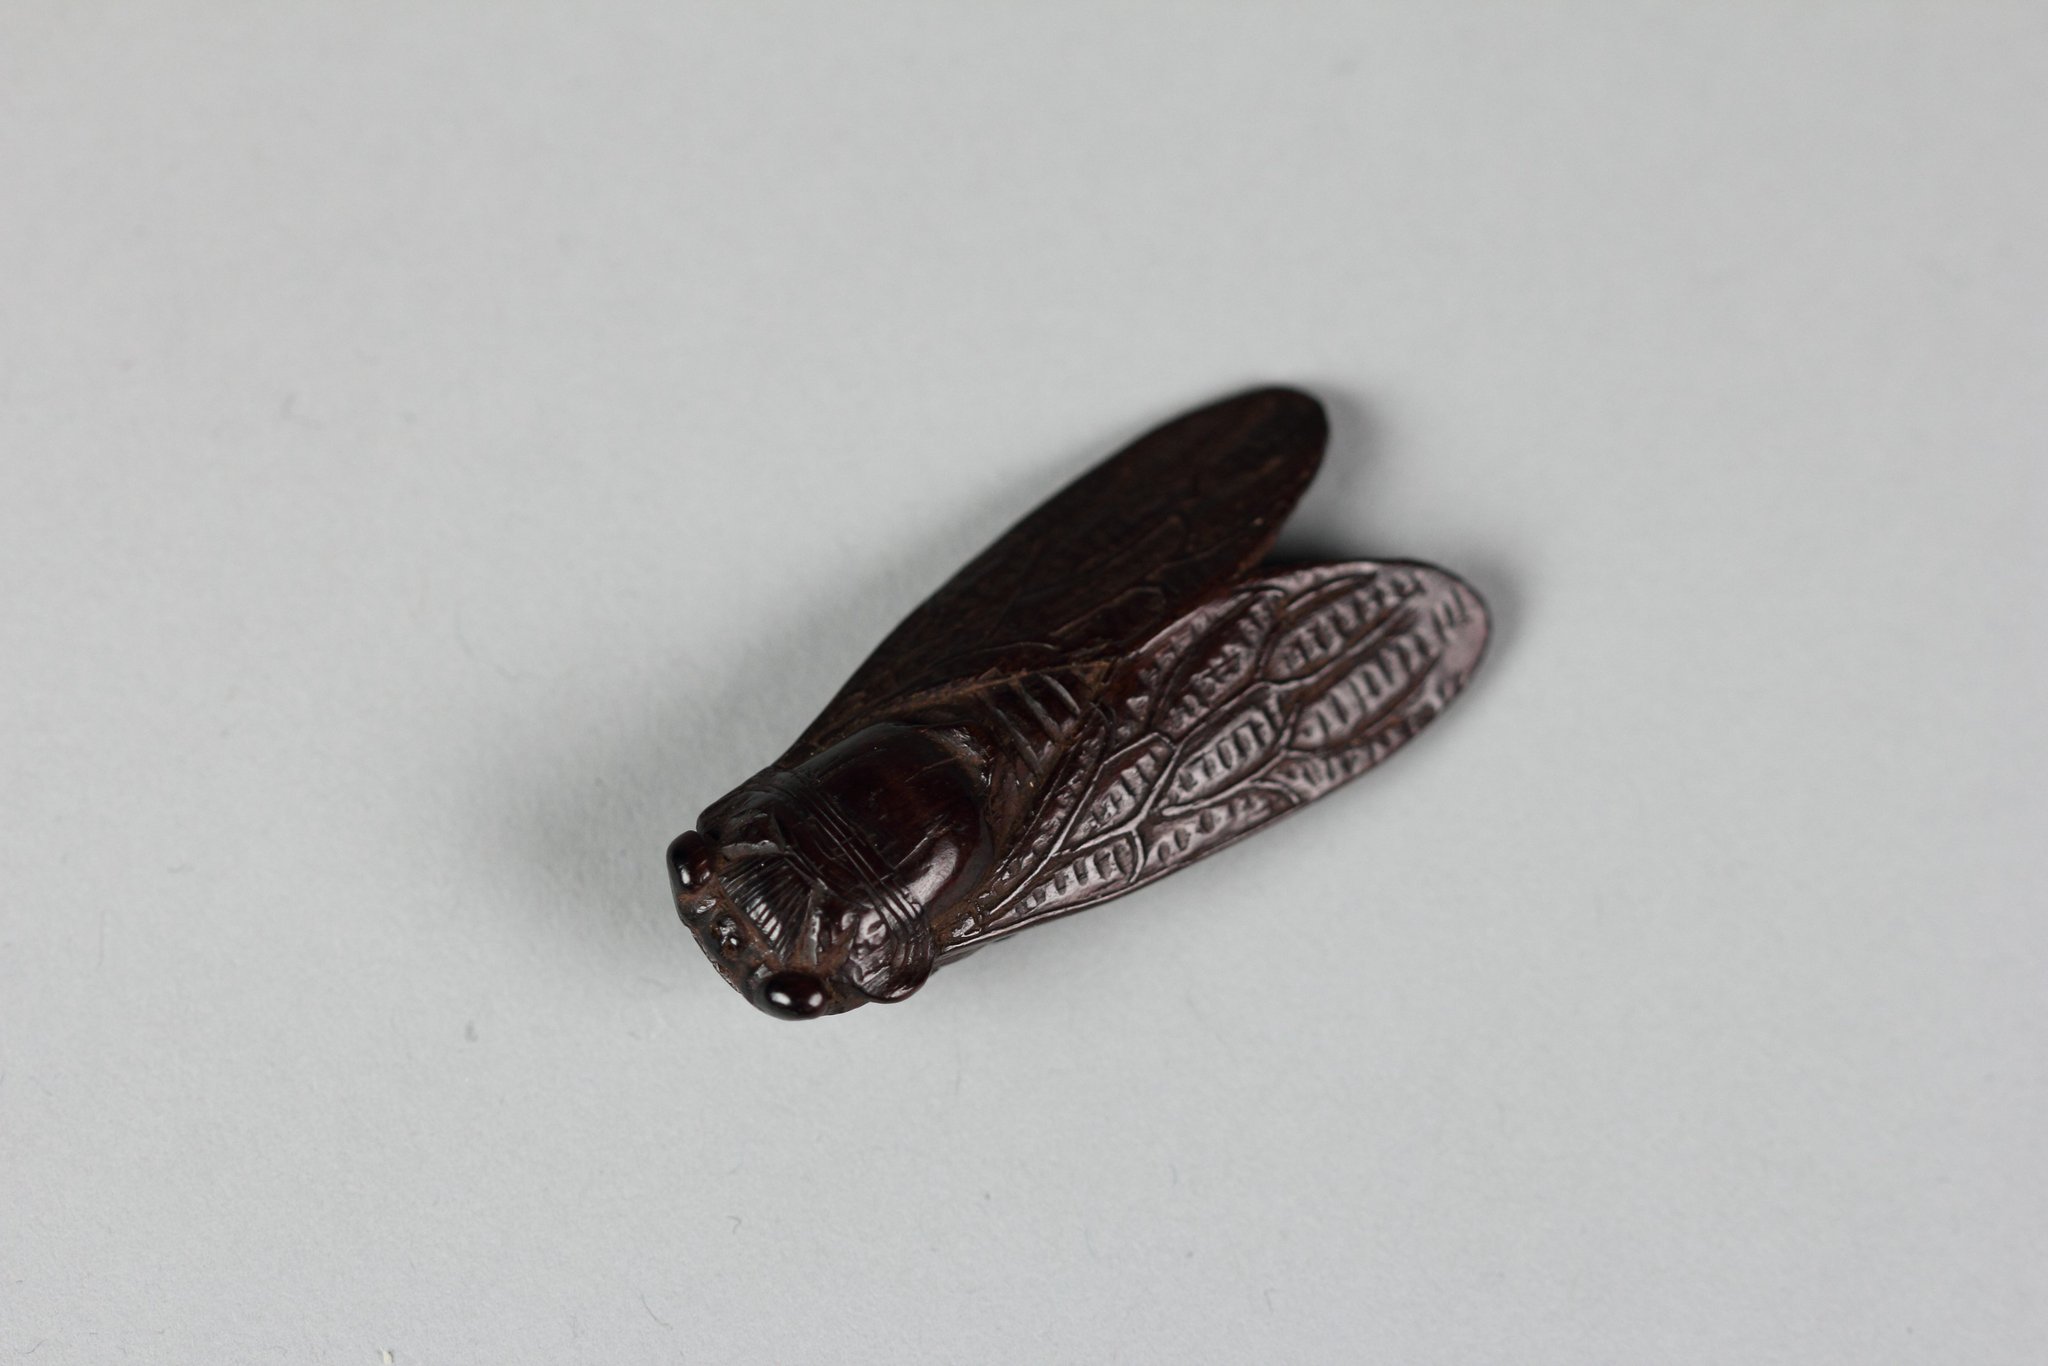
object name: netsuke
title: Netsuke of Cicada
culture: japanese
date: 1801-1900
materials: wood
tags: insects